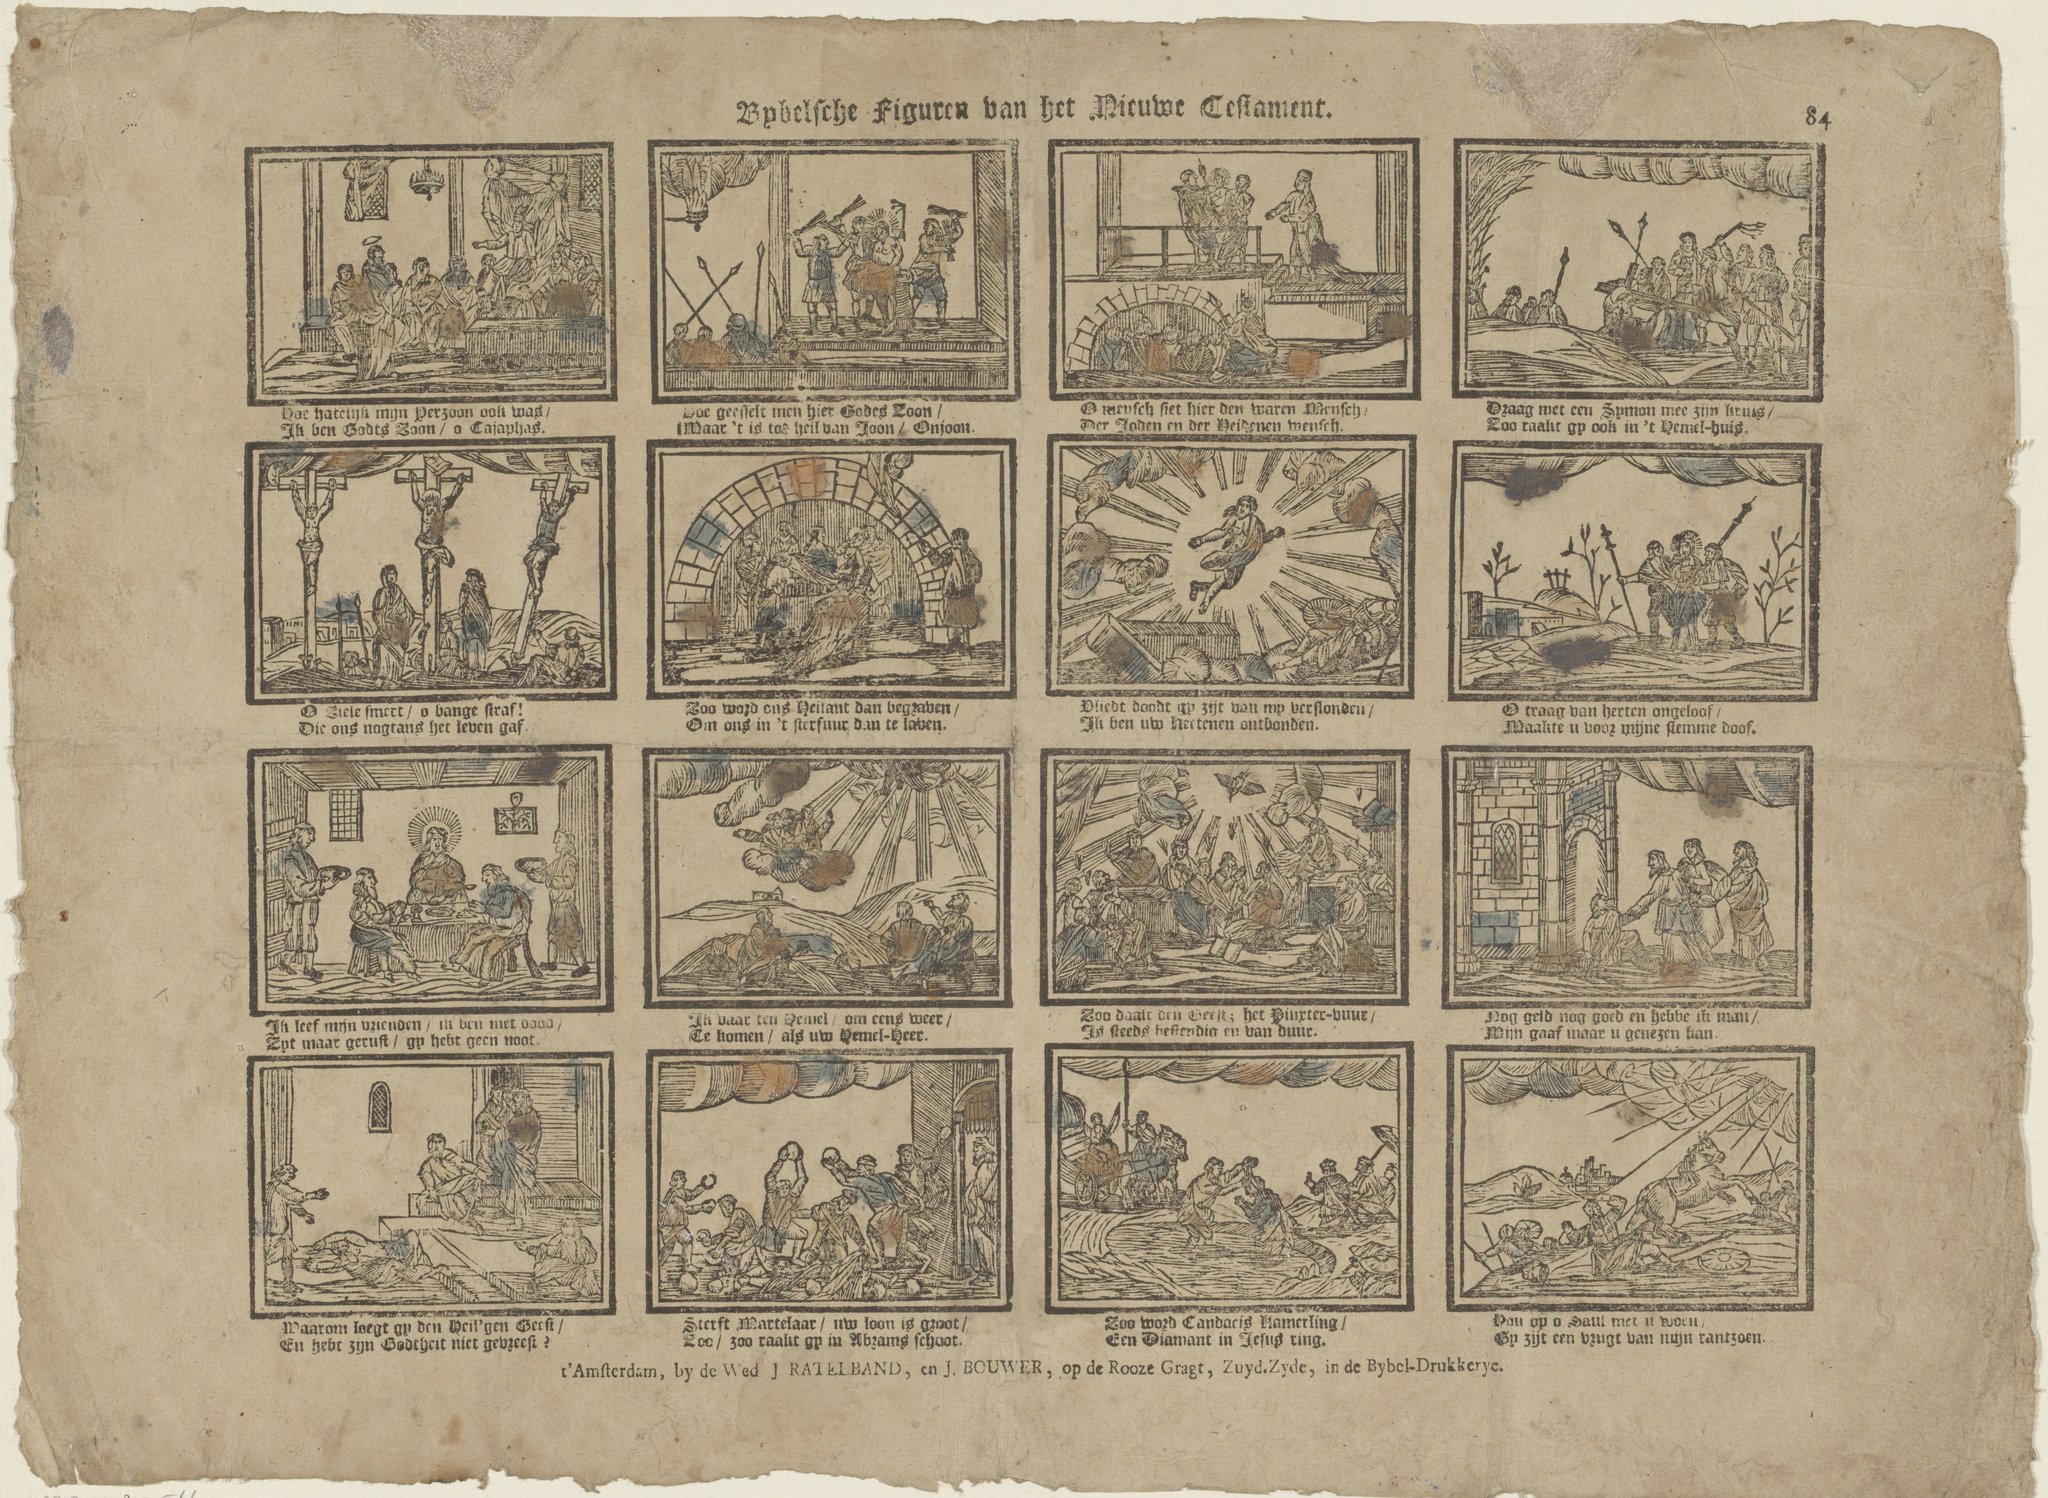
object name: popular print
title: Bijbelsche figuren van het Nieuwe Testament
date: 1767-1778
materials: paper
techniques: colour, letterpress printing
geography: netherlands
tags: new testament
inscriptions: collector's mark: Lugt 2760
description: Blad met 16 voorstellingen van verhalen uit het Nieuwe Testament. Onder elke afbeelding een tweeregelig vers. Genummerd rechtsboven: 84.